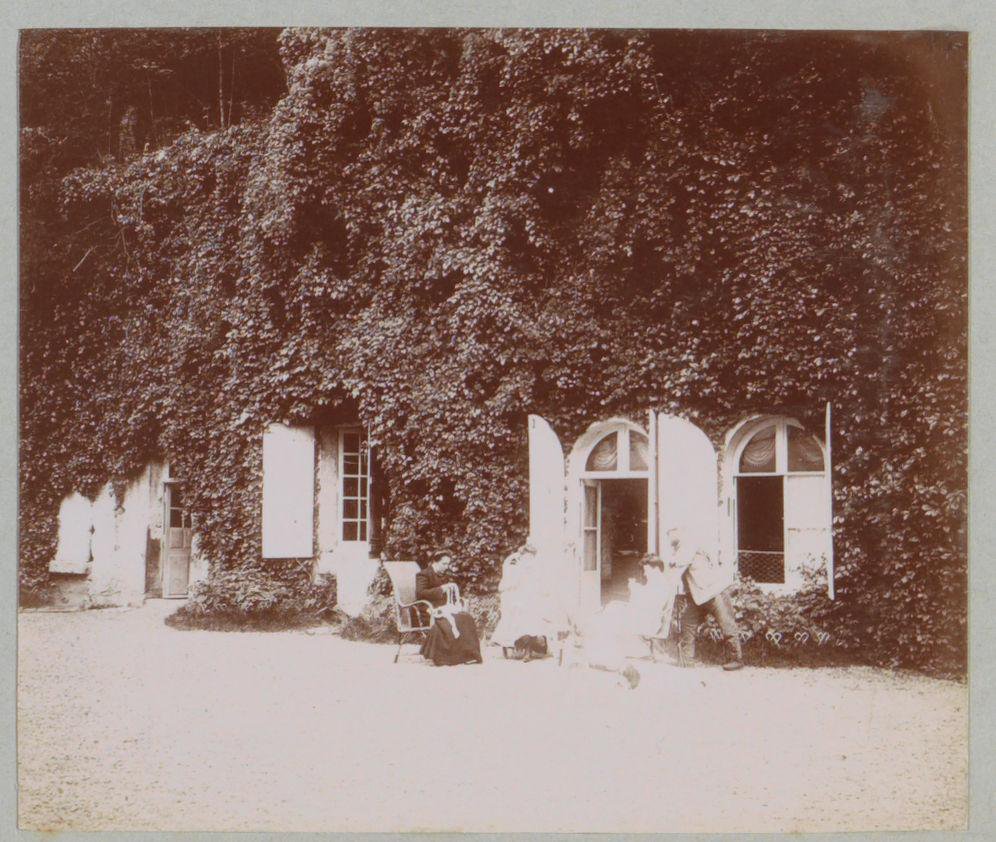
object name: photograph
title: Gezelschap zittend op een binnenplaats (aangeduid als 'La Charpenterie'), vermoedelijk bij een landhuis of kasteel in Frankrijk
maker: delizy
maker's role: manufacturer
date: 1903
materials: paper, photographic support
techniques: gelatin silver print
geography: france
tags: courtyard, plants and herbs: ivy, france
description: Onderdeel van Fotoalbum van een Franse amateurfotograaf met opnames van uitstapjes in Frankrijk, Spanje, België, Luxemburg en Nederland, de eerste automobielen en autoraces.